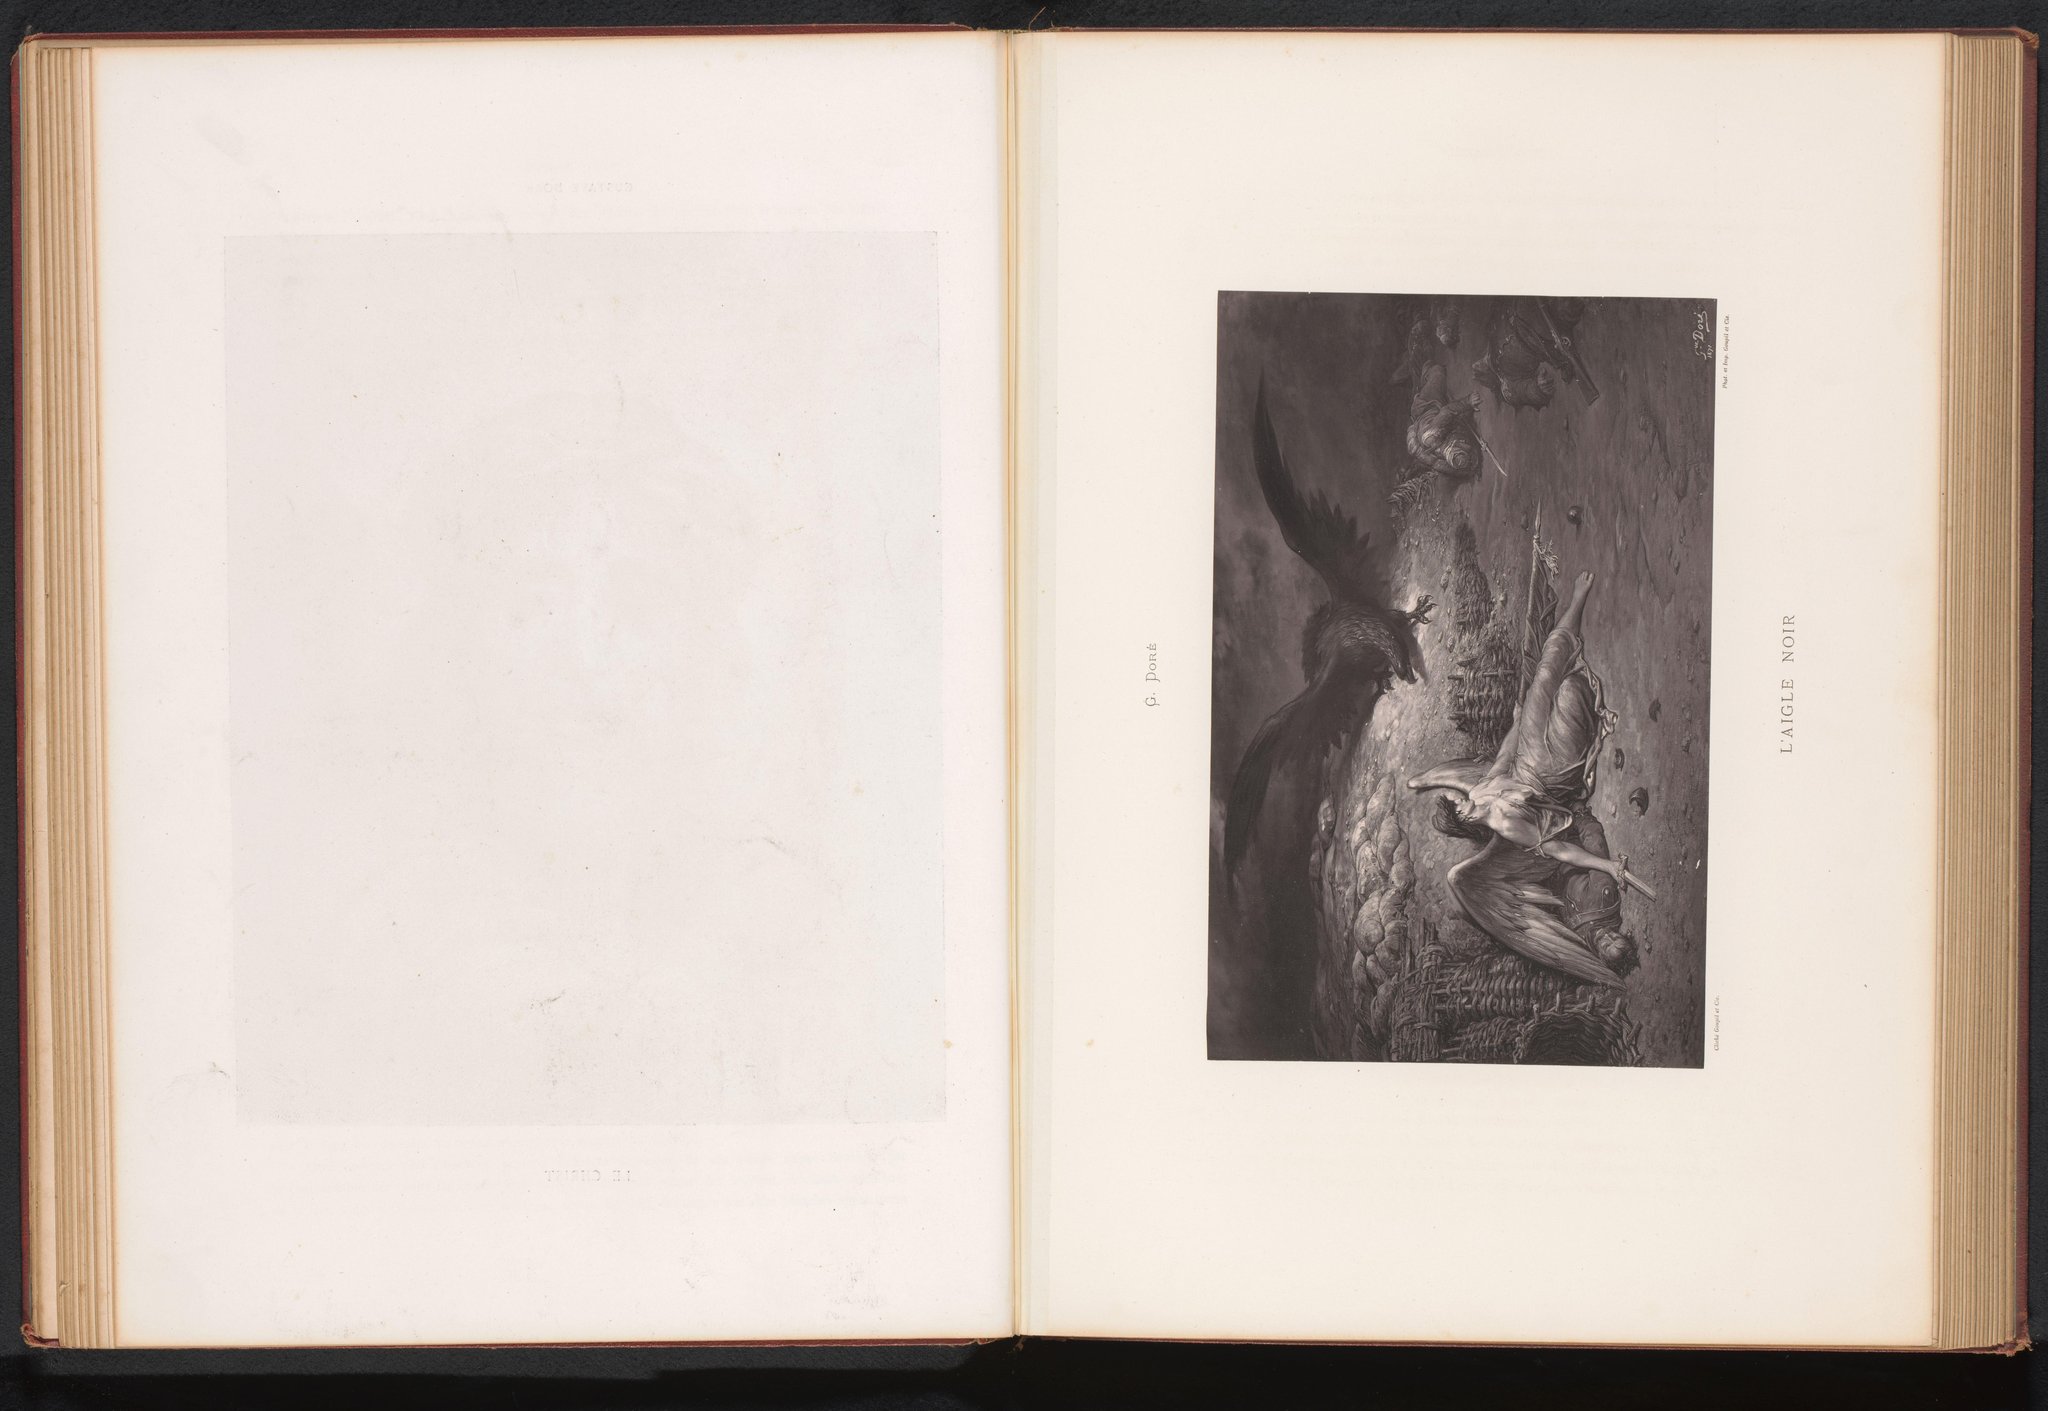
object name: page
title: Reproductie van L'Aigle Noir door Gustave Doré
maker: gustave doré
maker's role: draughtsman, print maker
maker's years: 1832-1883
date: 1874-1879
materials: paper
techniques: woodburytype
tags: predatory birds: eagle, the defeated (after the battle), angels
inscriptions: name: ‘G. Doré’